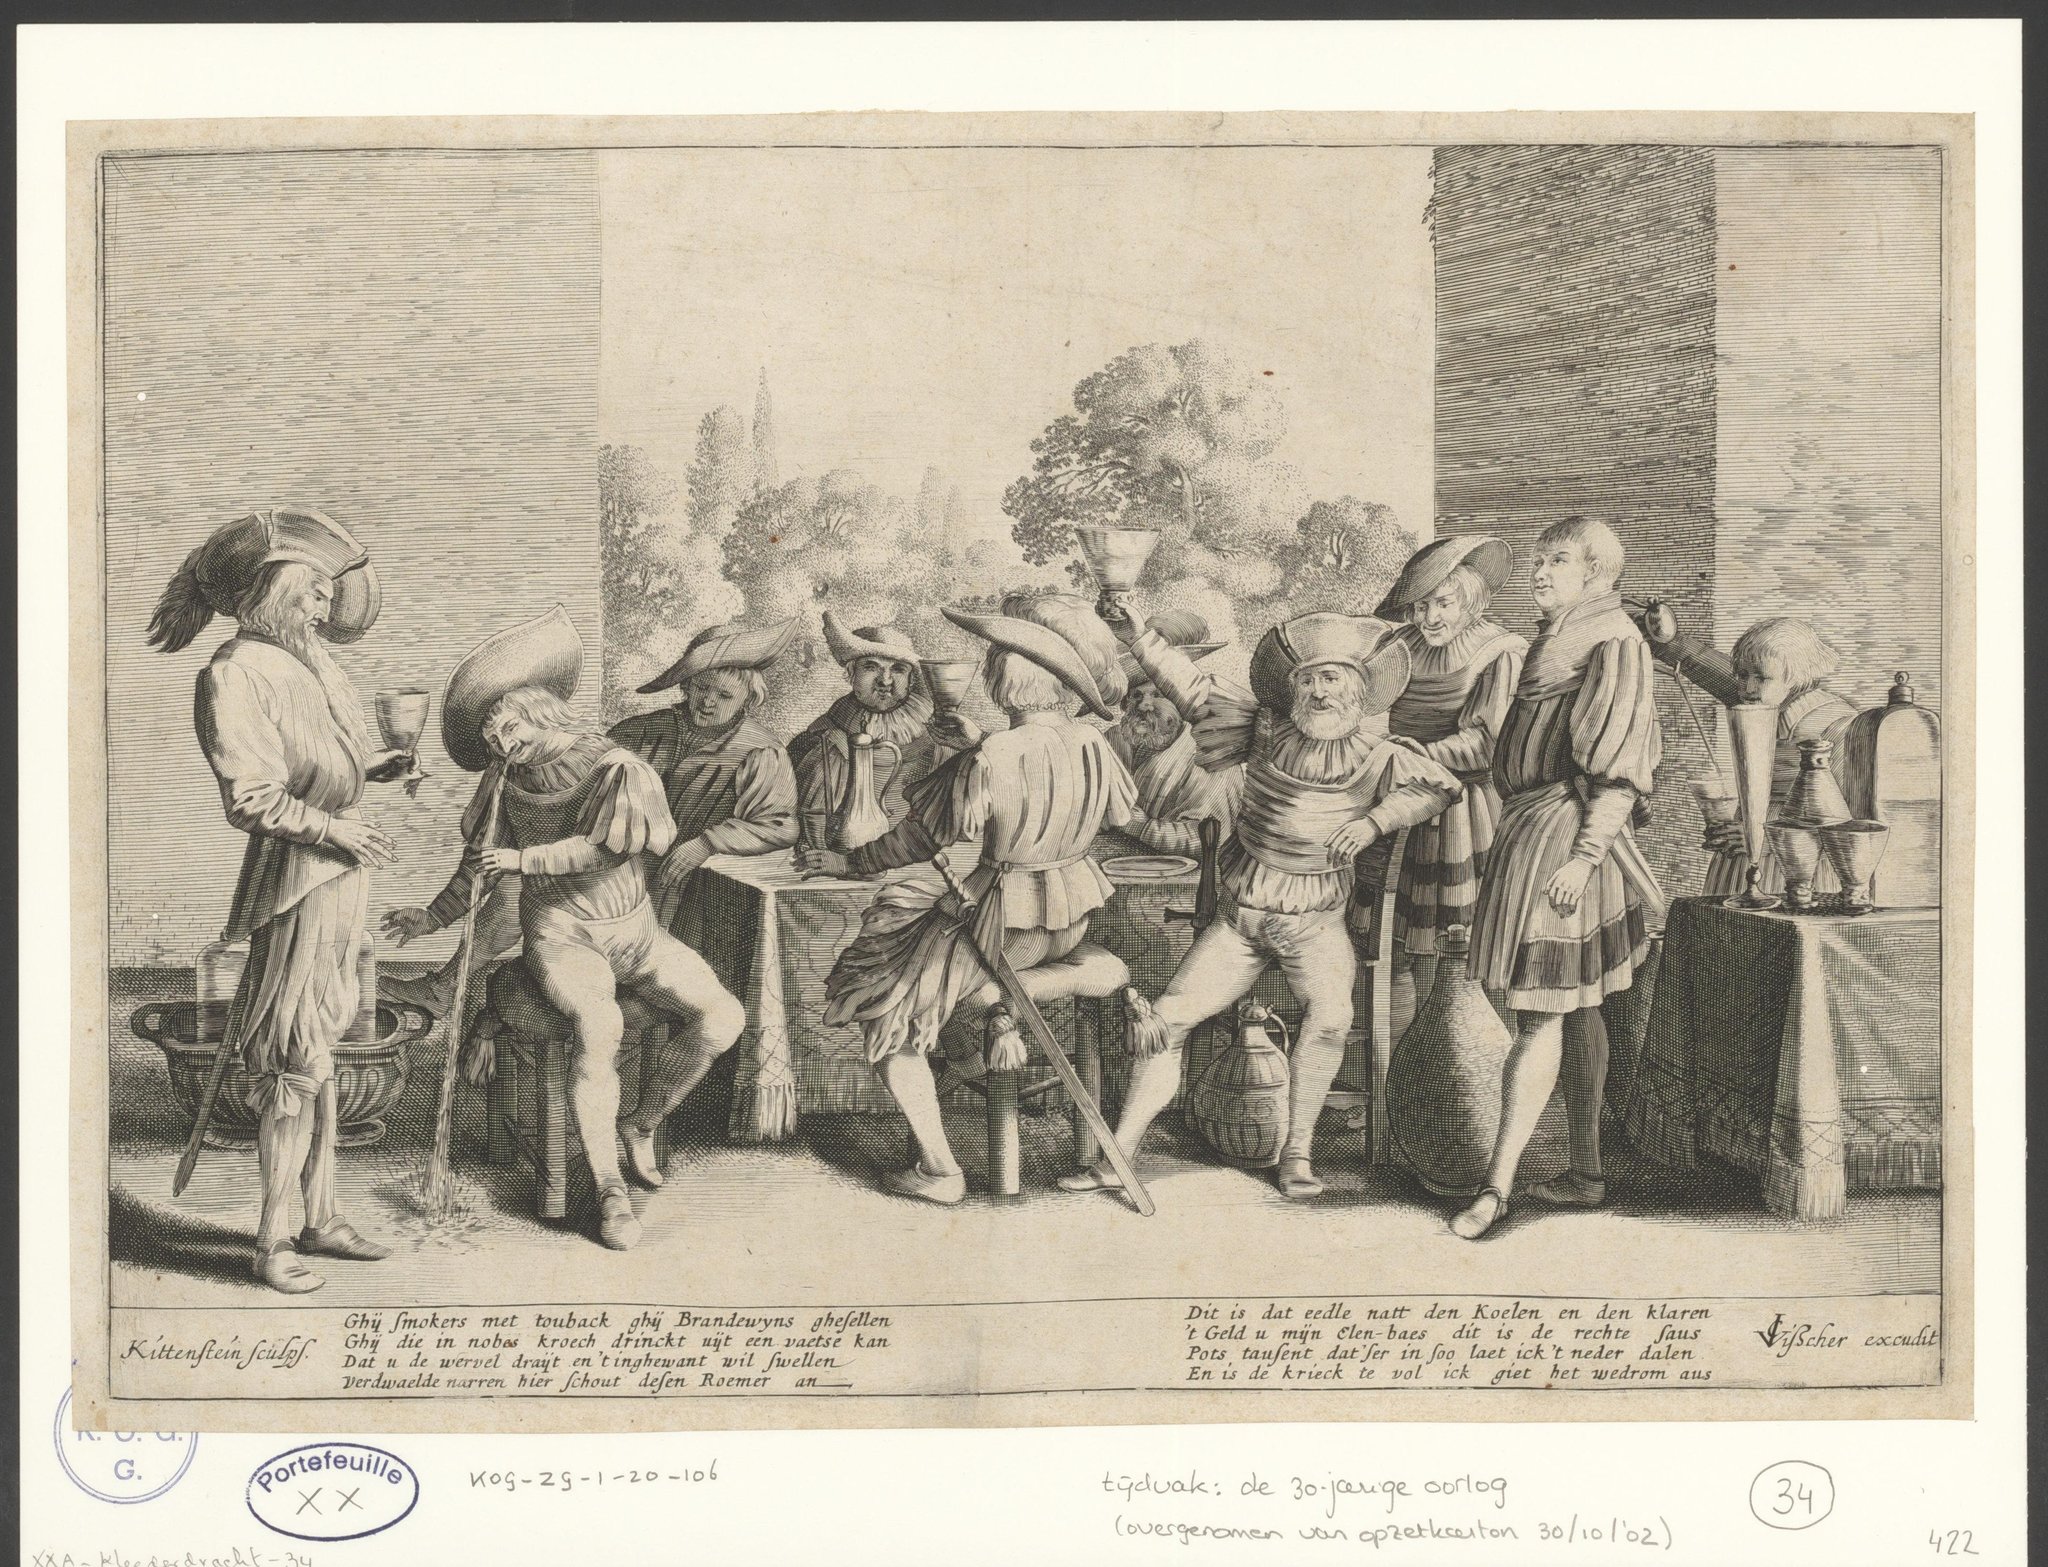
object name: print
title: Edellieden rond een rijk gedekte tafel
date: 1610-1652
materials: paper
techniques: engraving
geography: amsterdam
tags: vomiting, drunkenness, eating and drinking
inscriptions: collector's mark: Lugt 1641, stamp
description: Op een bordes bevindt zich een gezelschap edellieden aan een gedekte tafel, waar vooral veel wijnkannen en glazen op te zien zijn. In het midden heft een kleine man zijn glas. Links staat een oudere man - die ook een glas wijn in de hand heeft - te kijken naar de brakende man voor hem, terwijl een jongeman aan de rechterkant zijn glas nog eens goed volschenkt. Onder de afbeelding een Nederlandstalig vers in twee kolommen. Onderwerpsrubrieken binnen de Atlas Zeden en Gewoonten: Zeden en Gewoonten in Engeren Zin, De Kleeding, Kleederdrachten (tijdvakken), De 30-jarige oorlog. (1600 – 1650).